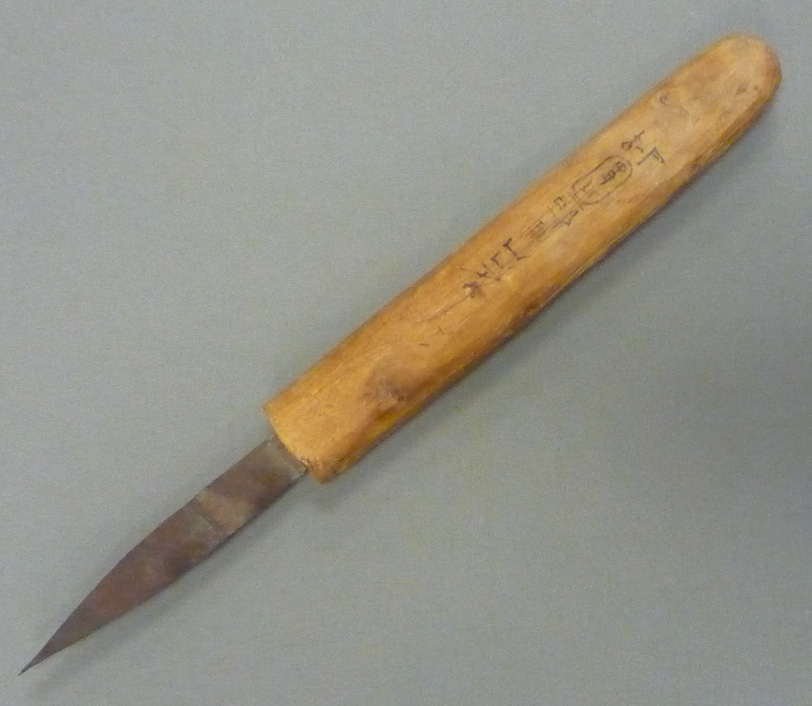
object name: chisel, carpenter, hatshepsut, maatkare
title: Carpenter's Chisel from a Foundation Deposit for Hatshepsut's Temple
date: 1479-1458 BCE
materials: bronze, copper alloy, wood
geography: egypt